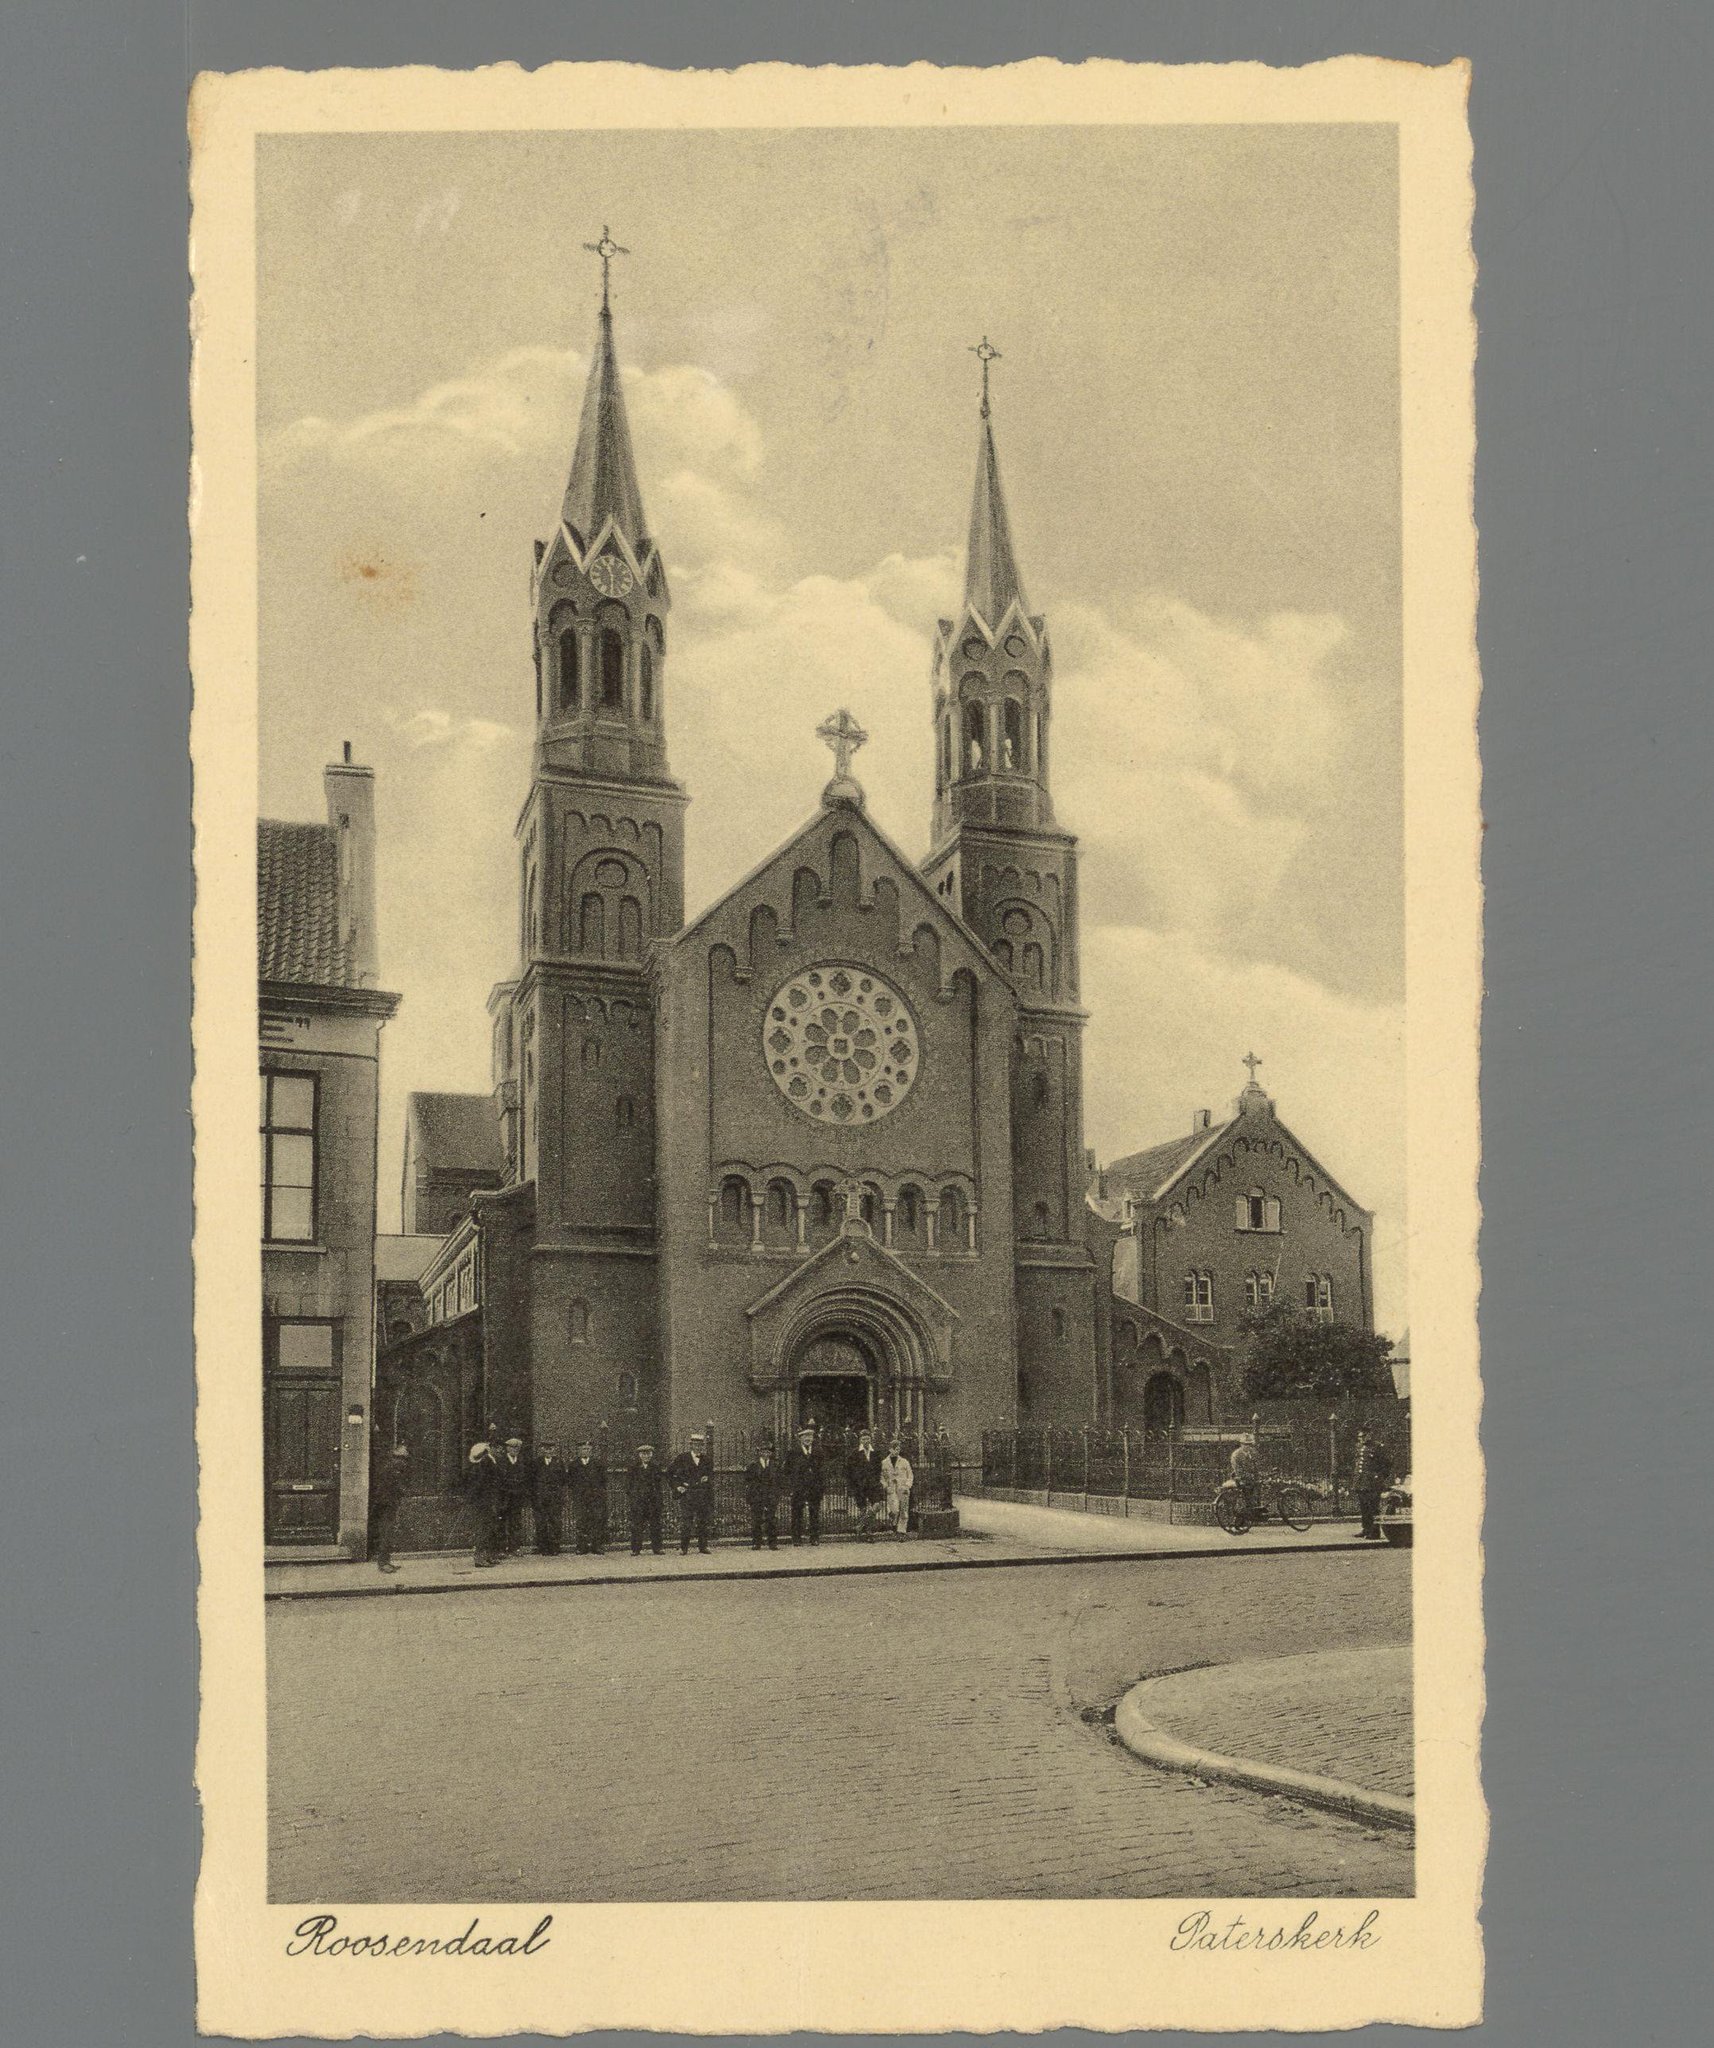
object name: ansichtkaart, prentbriefkaart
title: Roosendaal. Paterskerk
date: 1913-1937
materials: cardboard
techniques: photograph, writing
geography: amsterdam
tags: church (exterior)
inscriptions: postage stamp